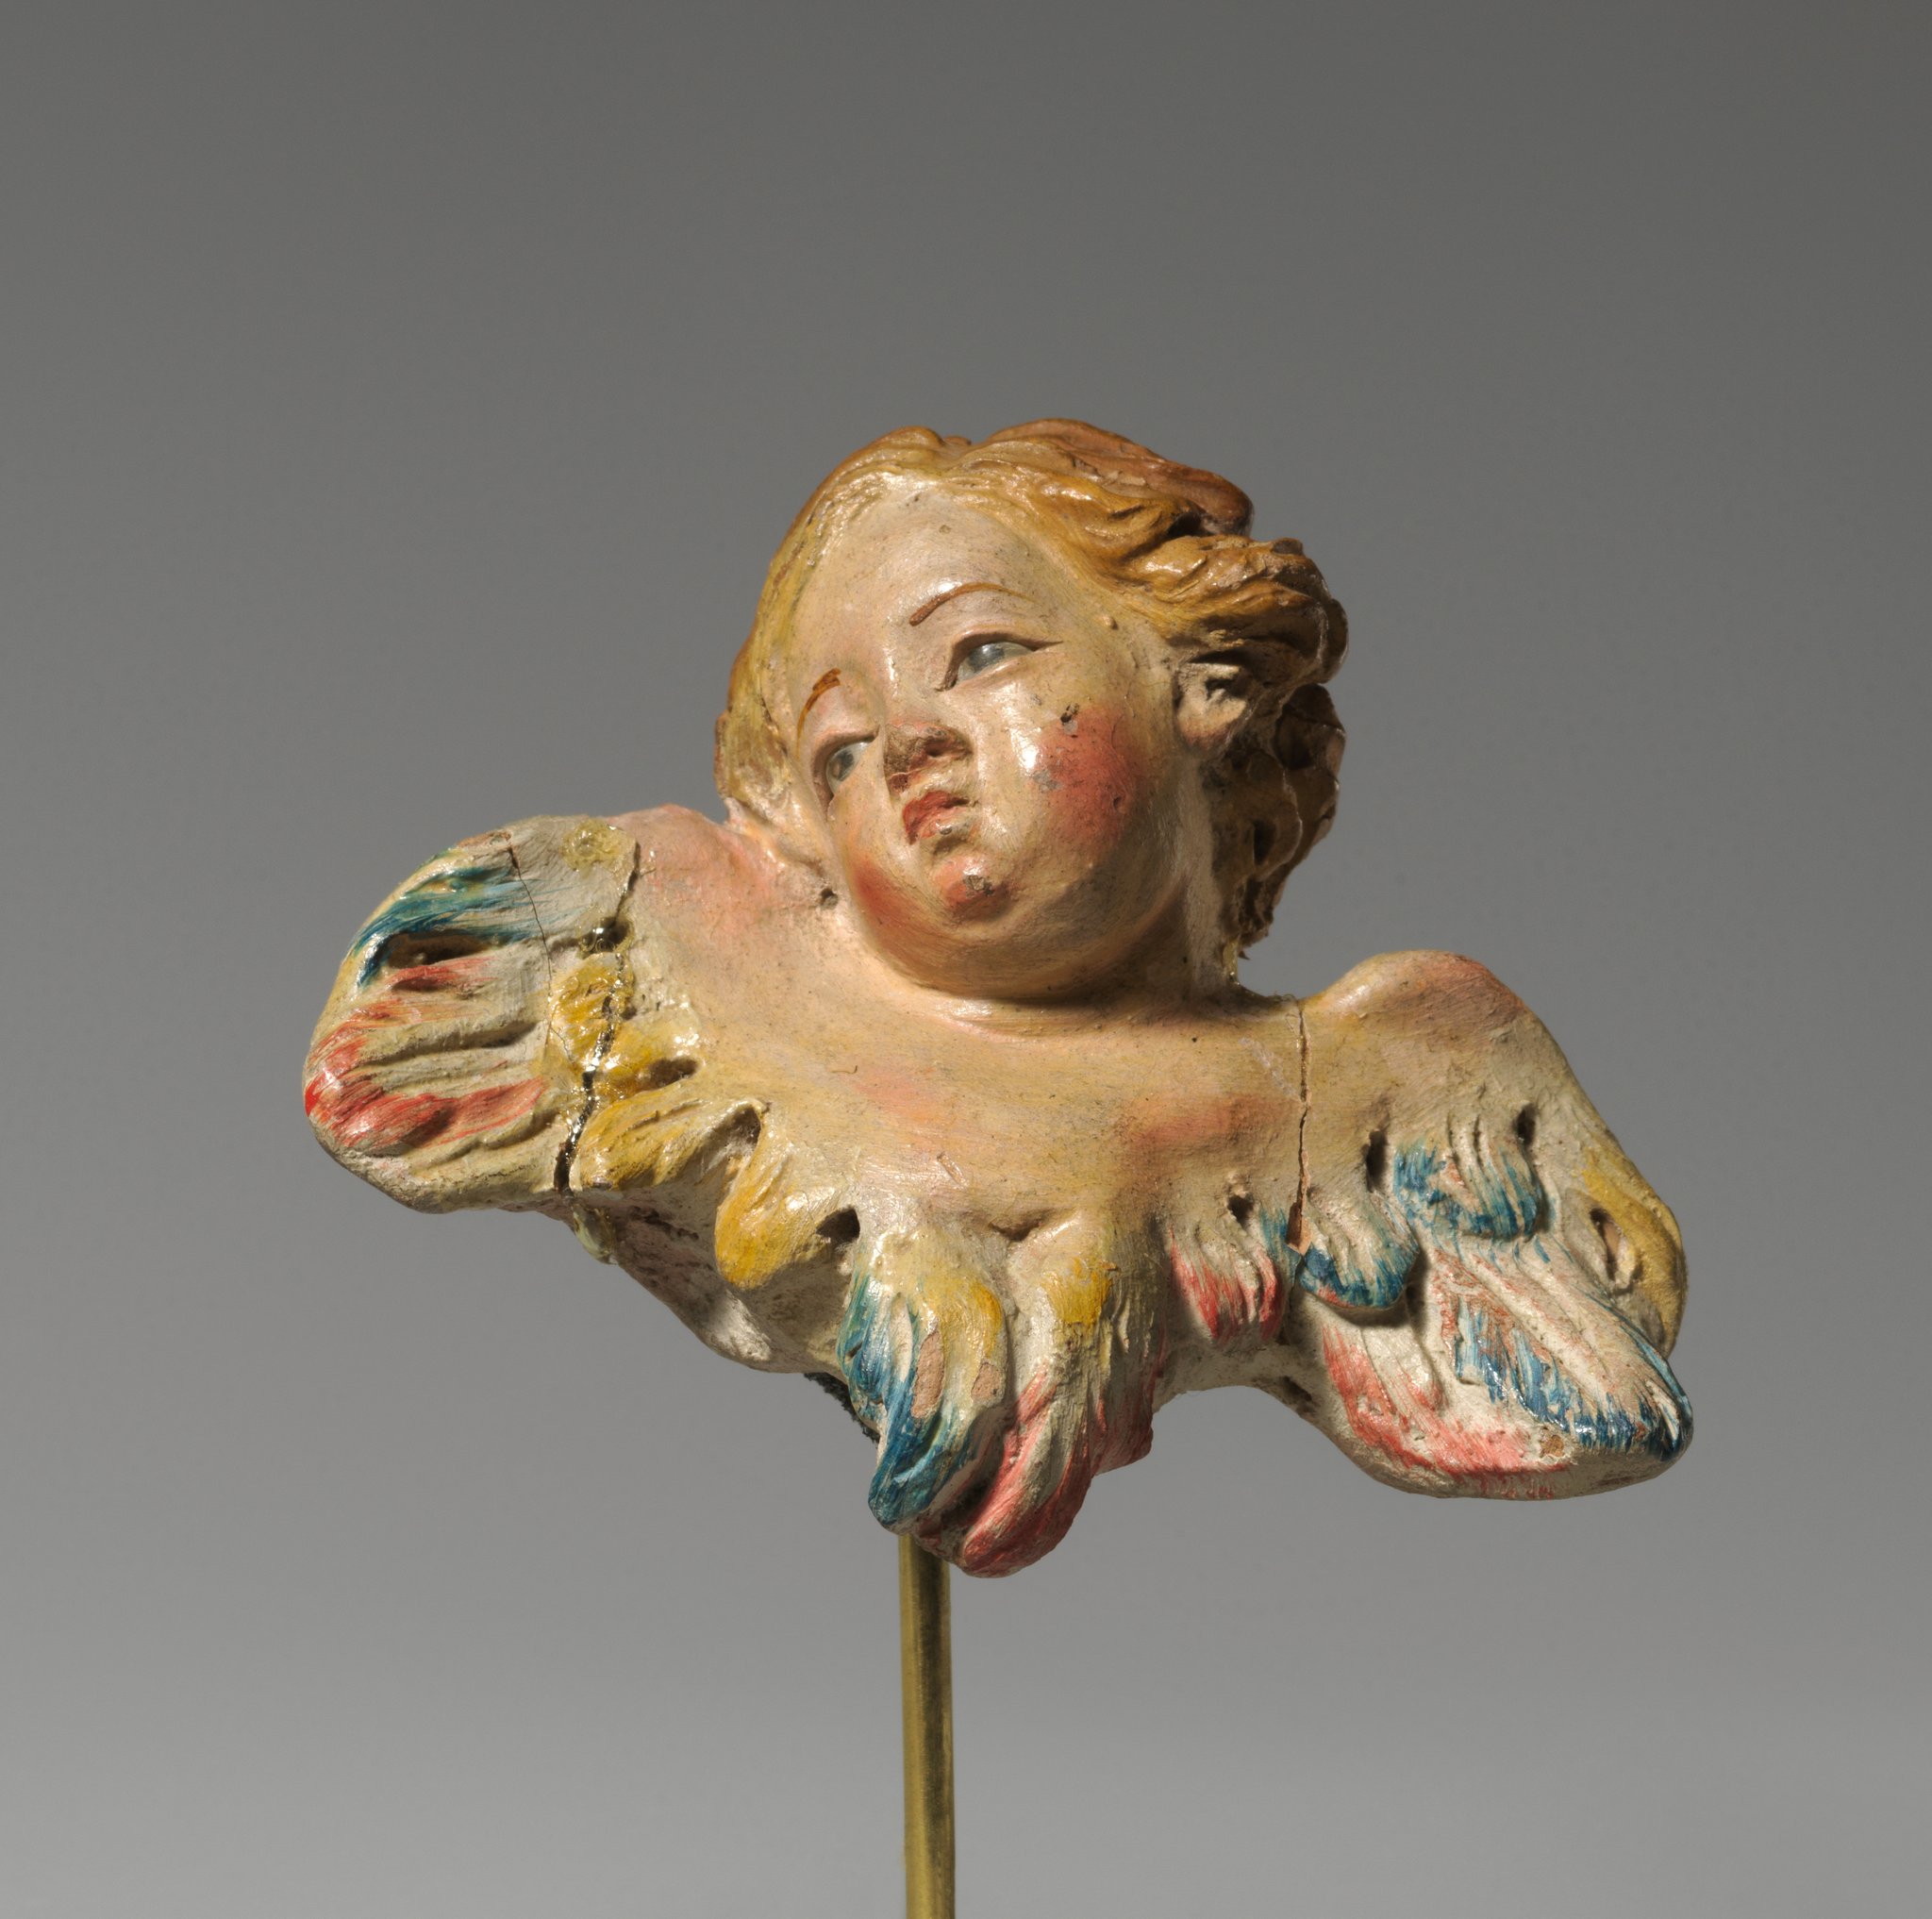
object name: crèche figure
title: Putto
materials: terracotta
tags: putti